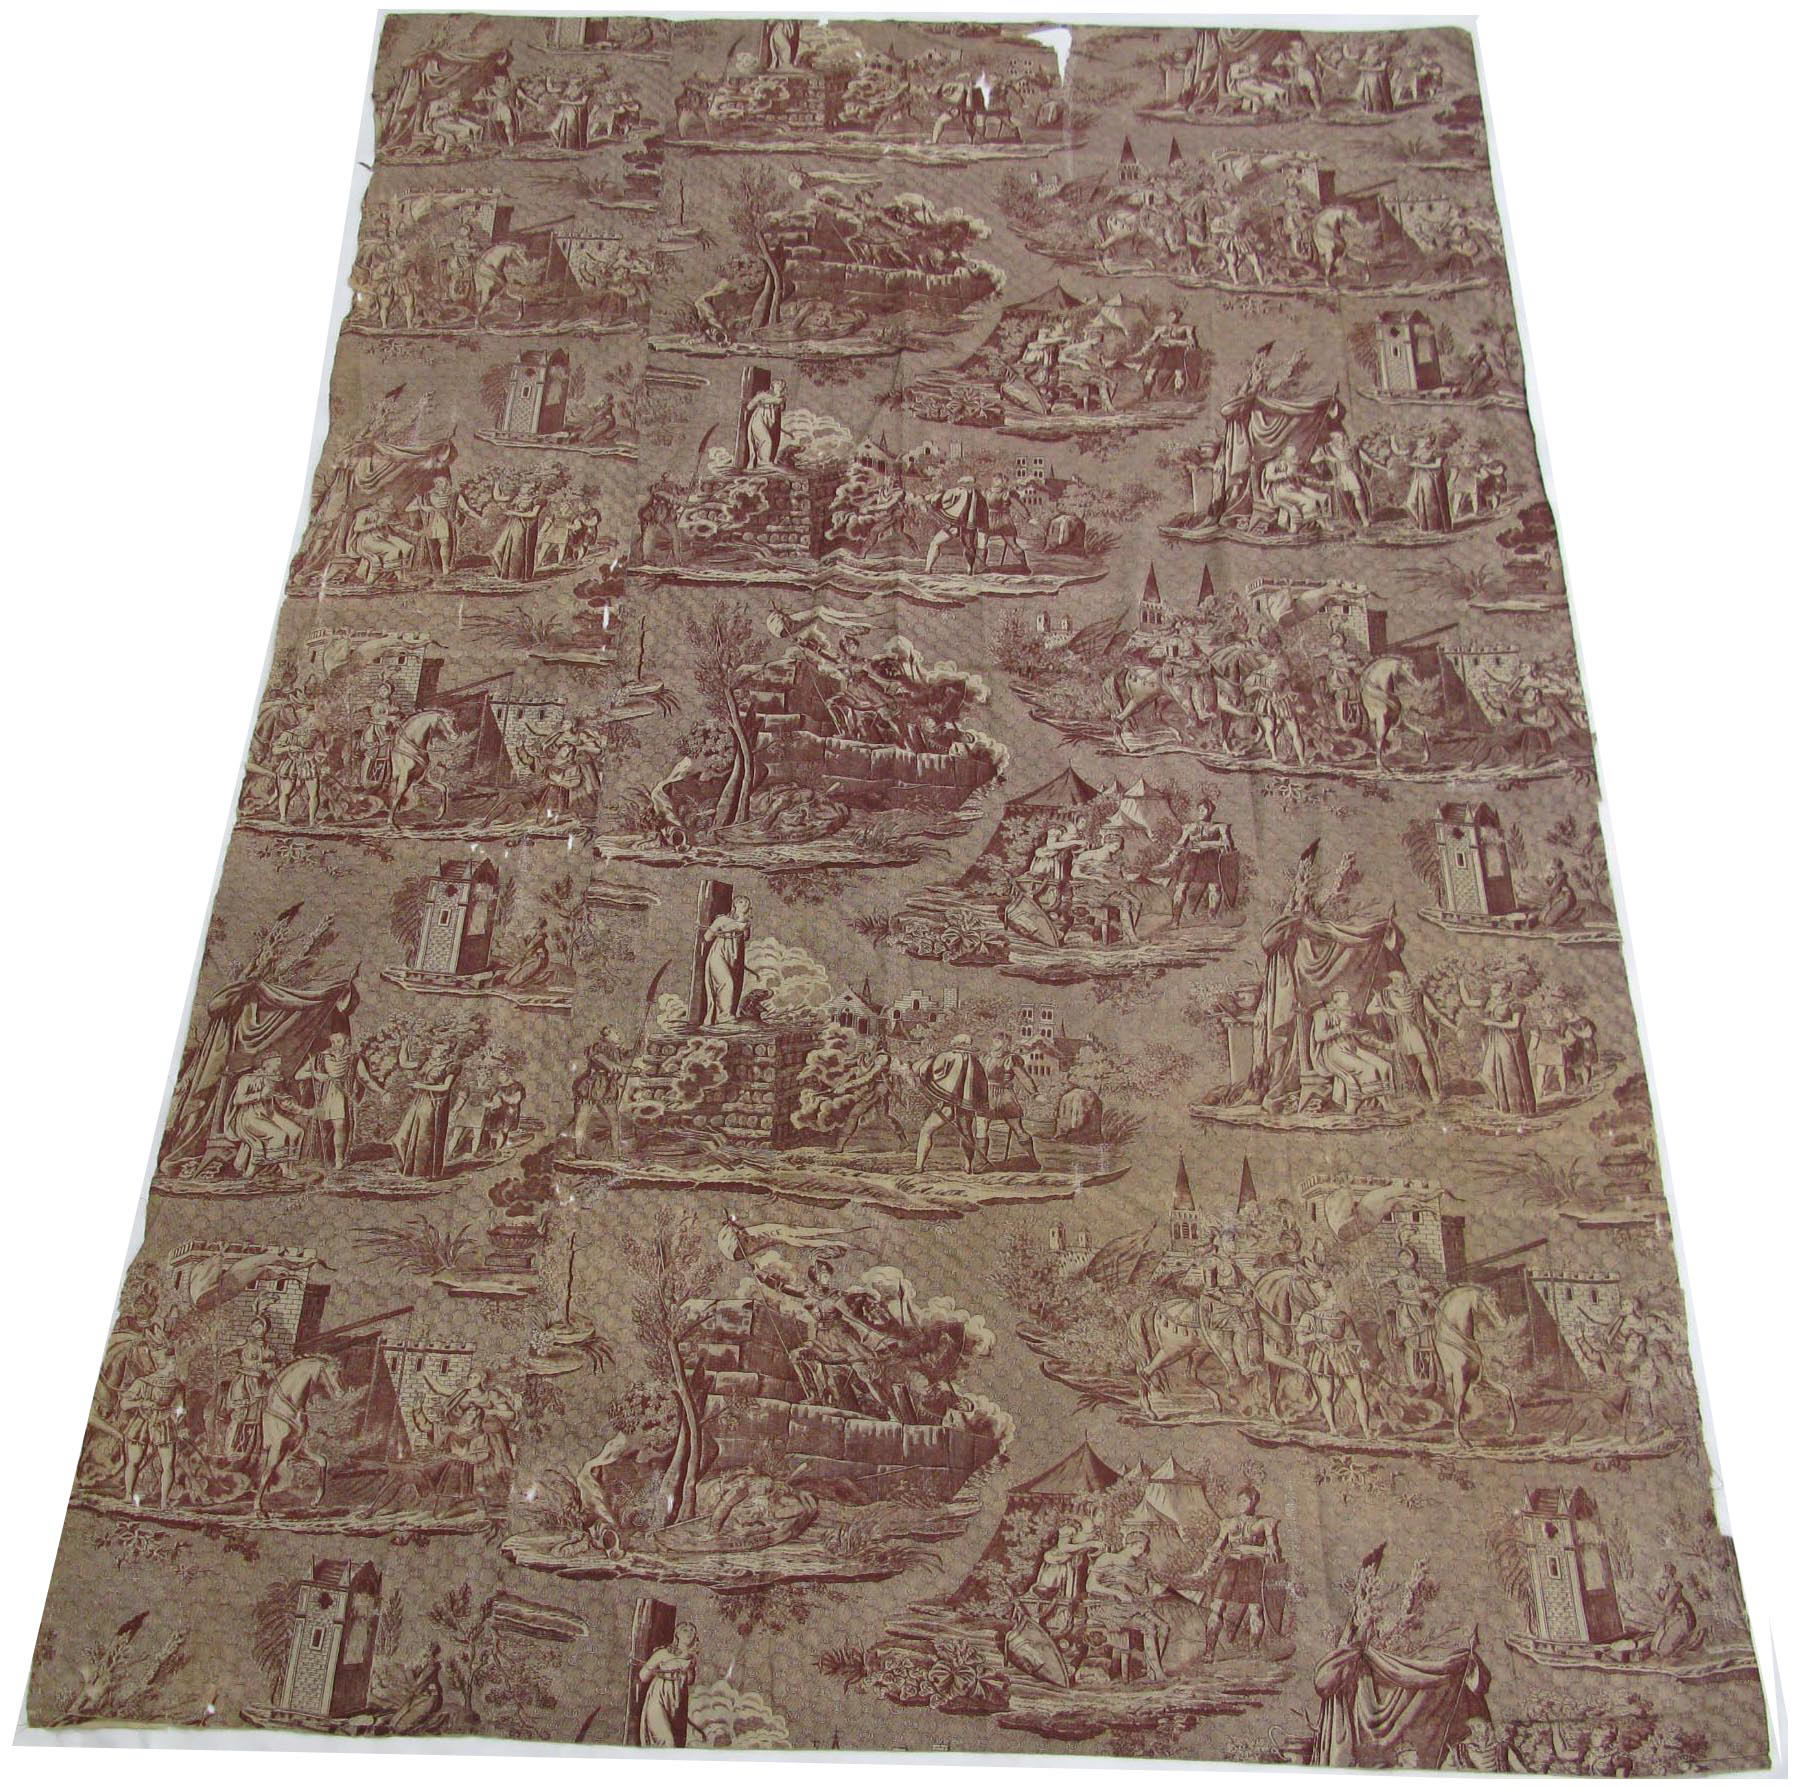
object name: length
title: Joan of Arc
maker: charles abraham chasselat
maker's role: designer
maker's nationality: french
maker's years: 1782-1843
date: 1801-1825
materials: cotton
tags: soldiers,shields,men,women,horses